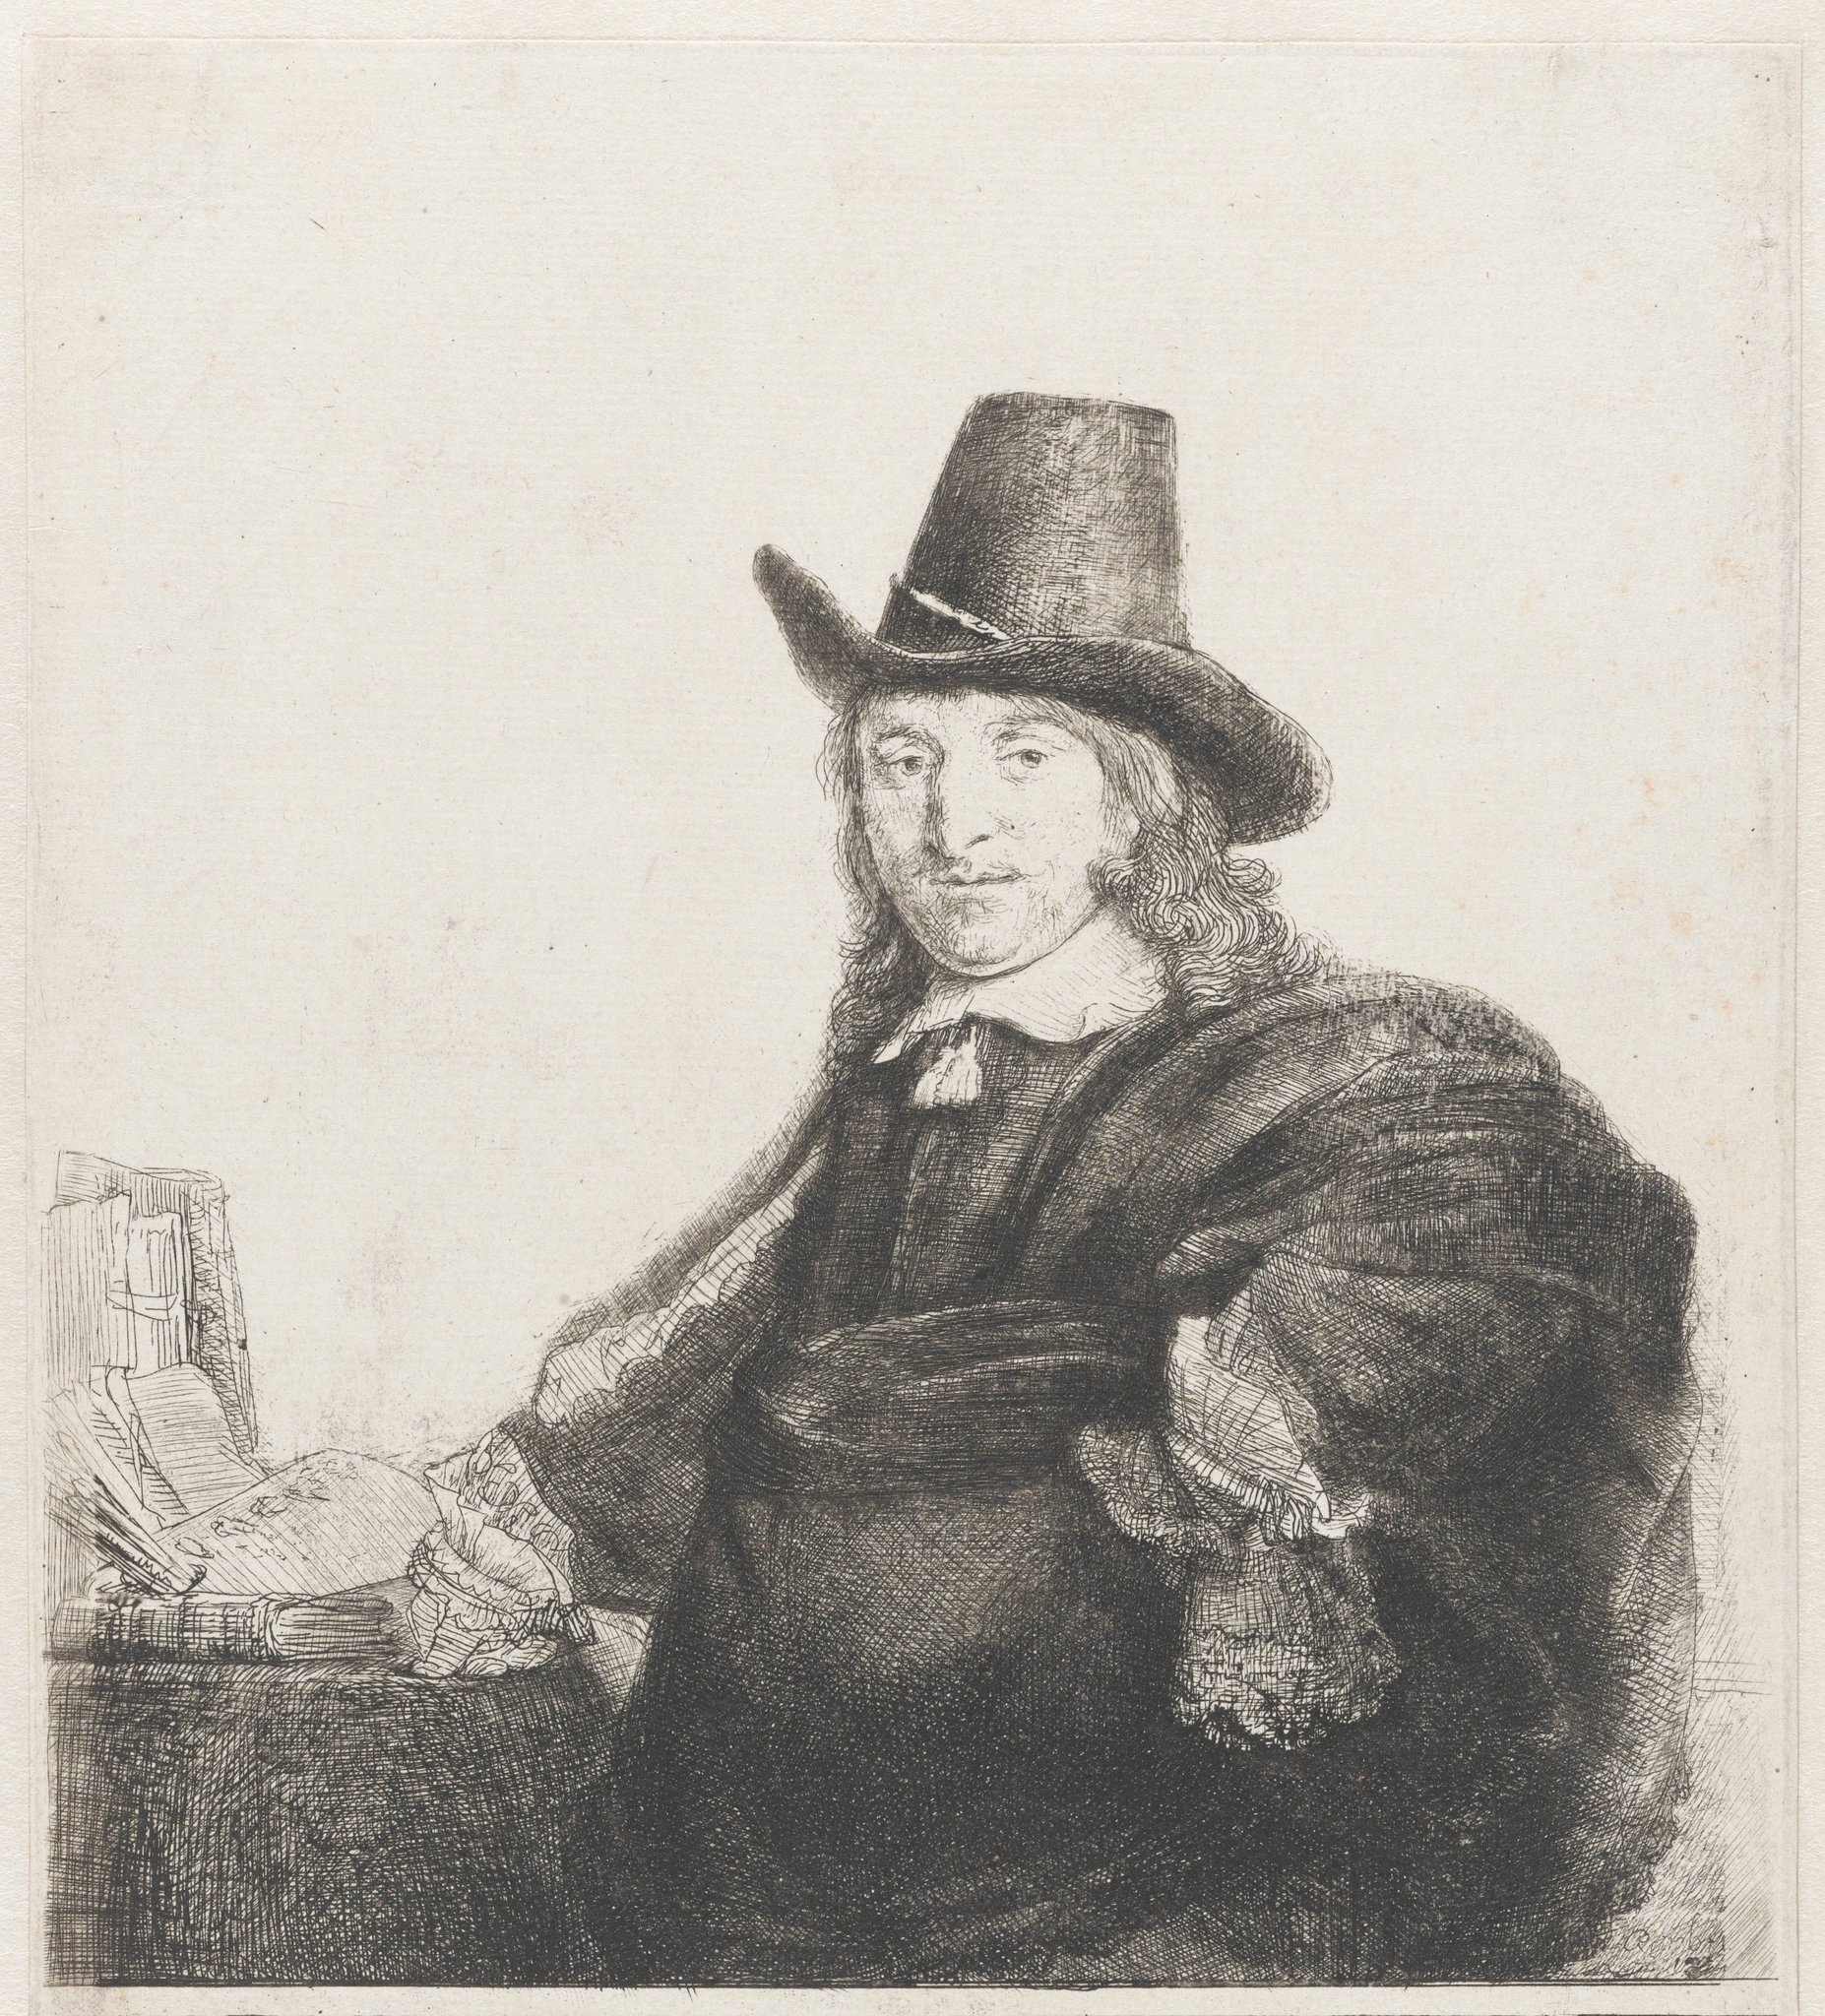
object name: print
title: Jan Asselijn, painter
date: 1647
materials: paper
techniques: drypoint, etching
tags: draughtsman, jan asselijn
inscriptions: mark: Lugt 2228, signature and date: ‘Rembr / f 16’, mark: Lugt 2760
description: Behoort tot de Verzameling Gerritsen, kunstenaarsportretten